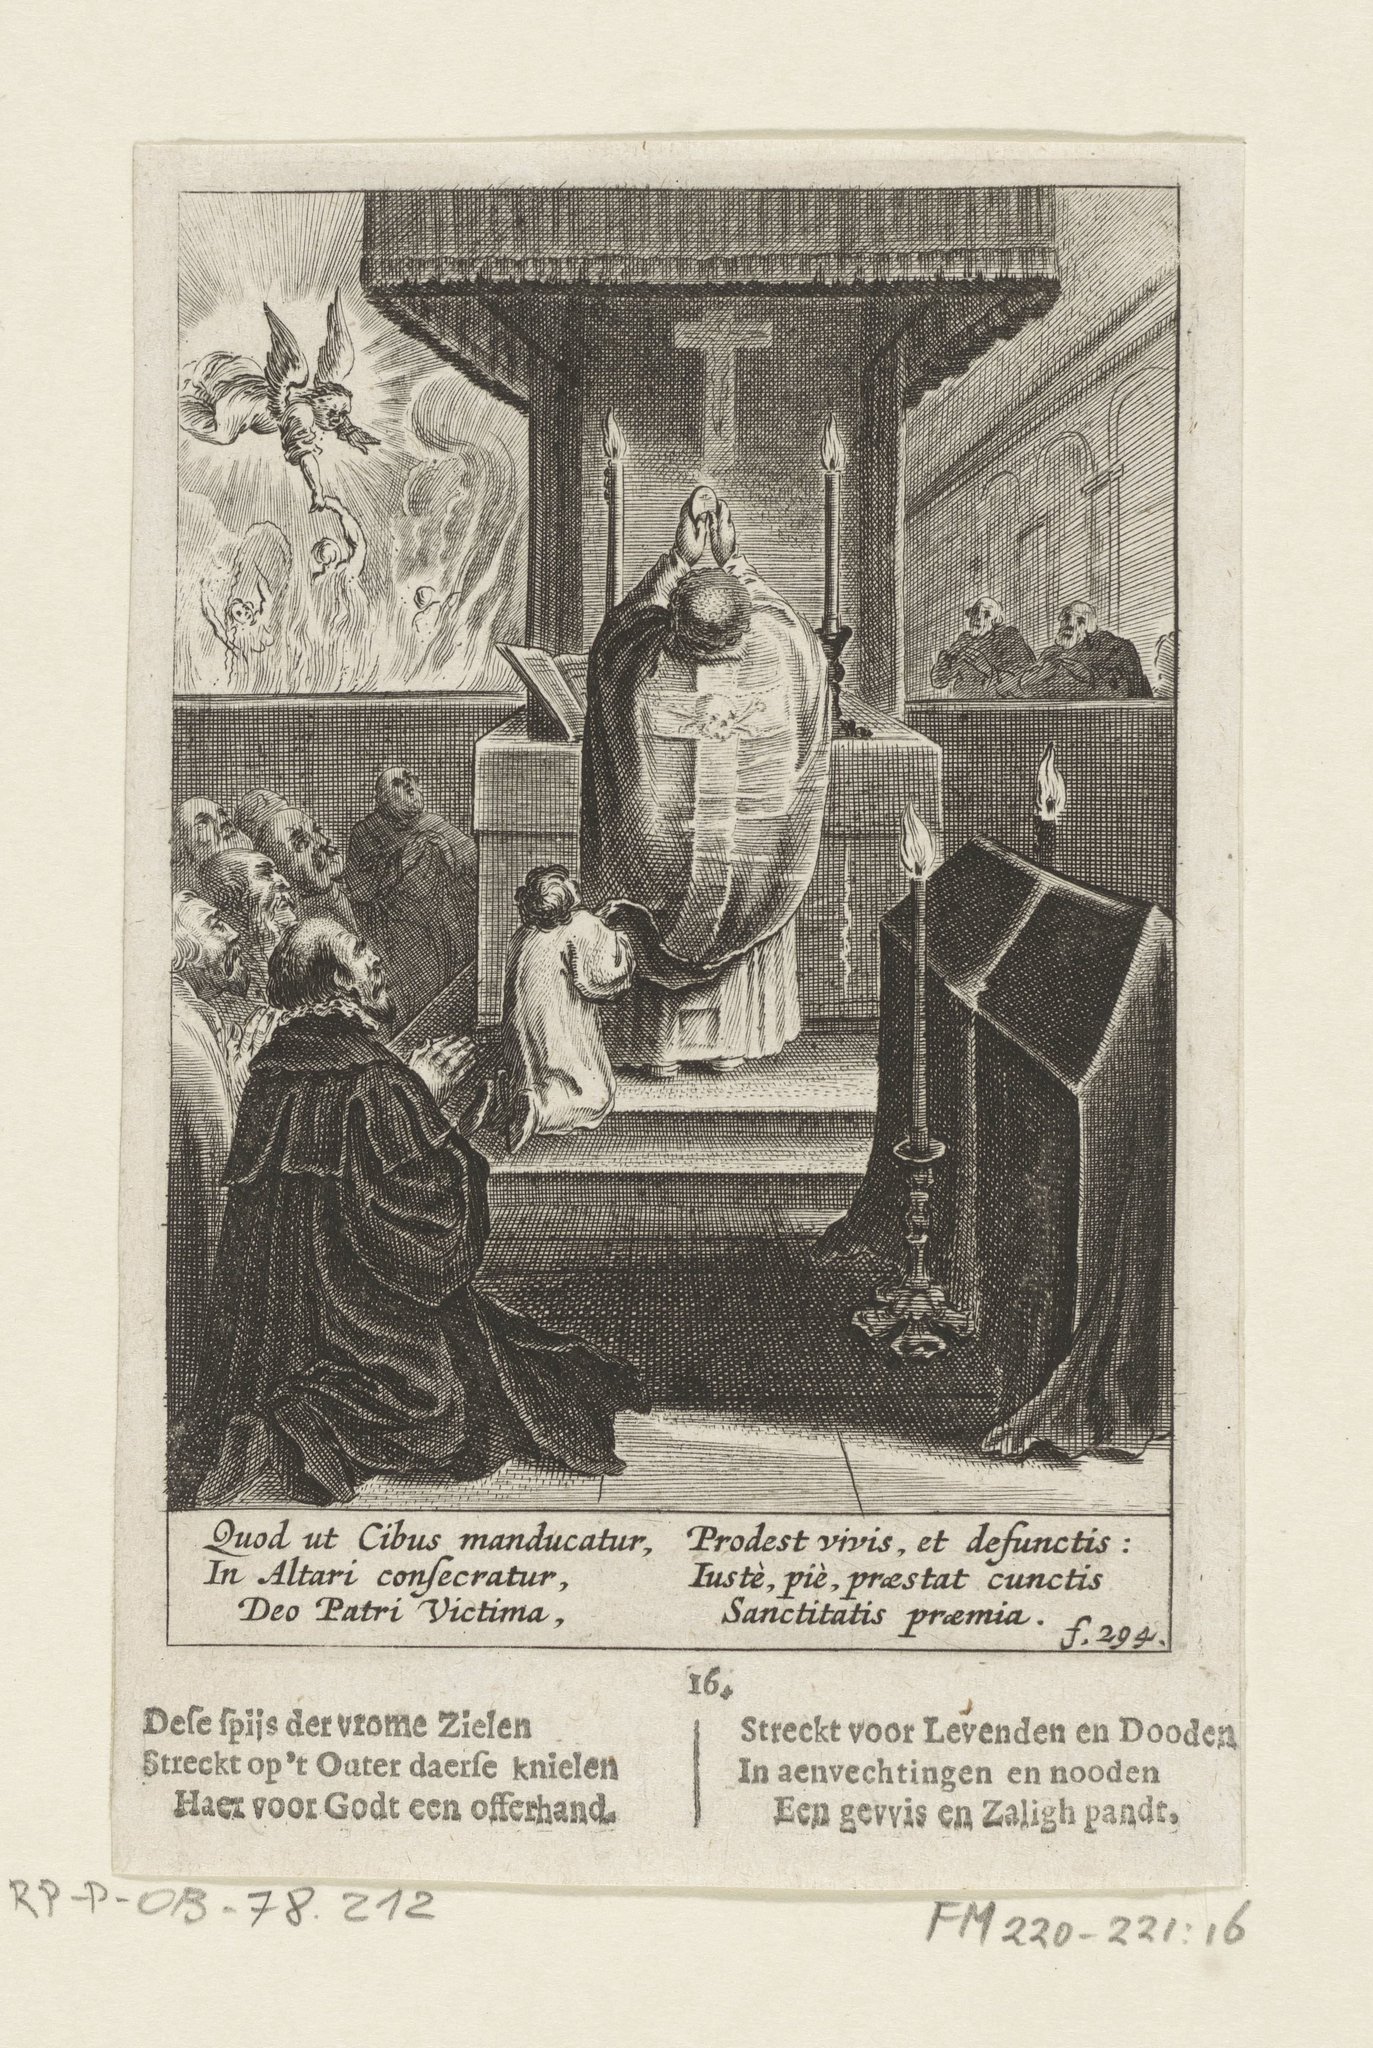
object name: print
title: Het Mirakel van Amsterdam (kopie), 1345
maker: Anonymous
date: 1639-1699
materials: paper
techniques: engraving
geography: low countries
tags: office of the dead, amsterdam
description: De lijkdienst. De priester houdt het H. Sacrament omhoog. Rechts op de achtergrond redt een engel een ziel uit het vagevuur. Op de voorgrond links de doodskist onder een kleed, rechts knielende mannen. Prent nr. 16 uit de serie van 16 voorstellingen van Het Mirakel van Amsterdam, naar de gebeurtenissen op 15 maart 1345. Kopieën naar de reeks van Bolswert. Onder de voorstelling in de plaat gegraveerd een zesregelig vers in het Latijn, daaronder een zesregelig vers in boekdruk in het Nederlands.